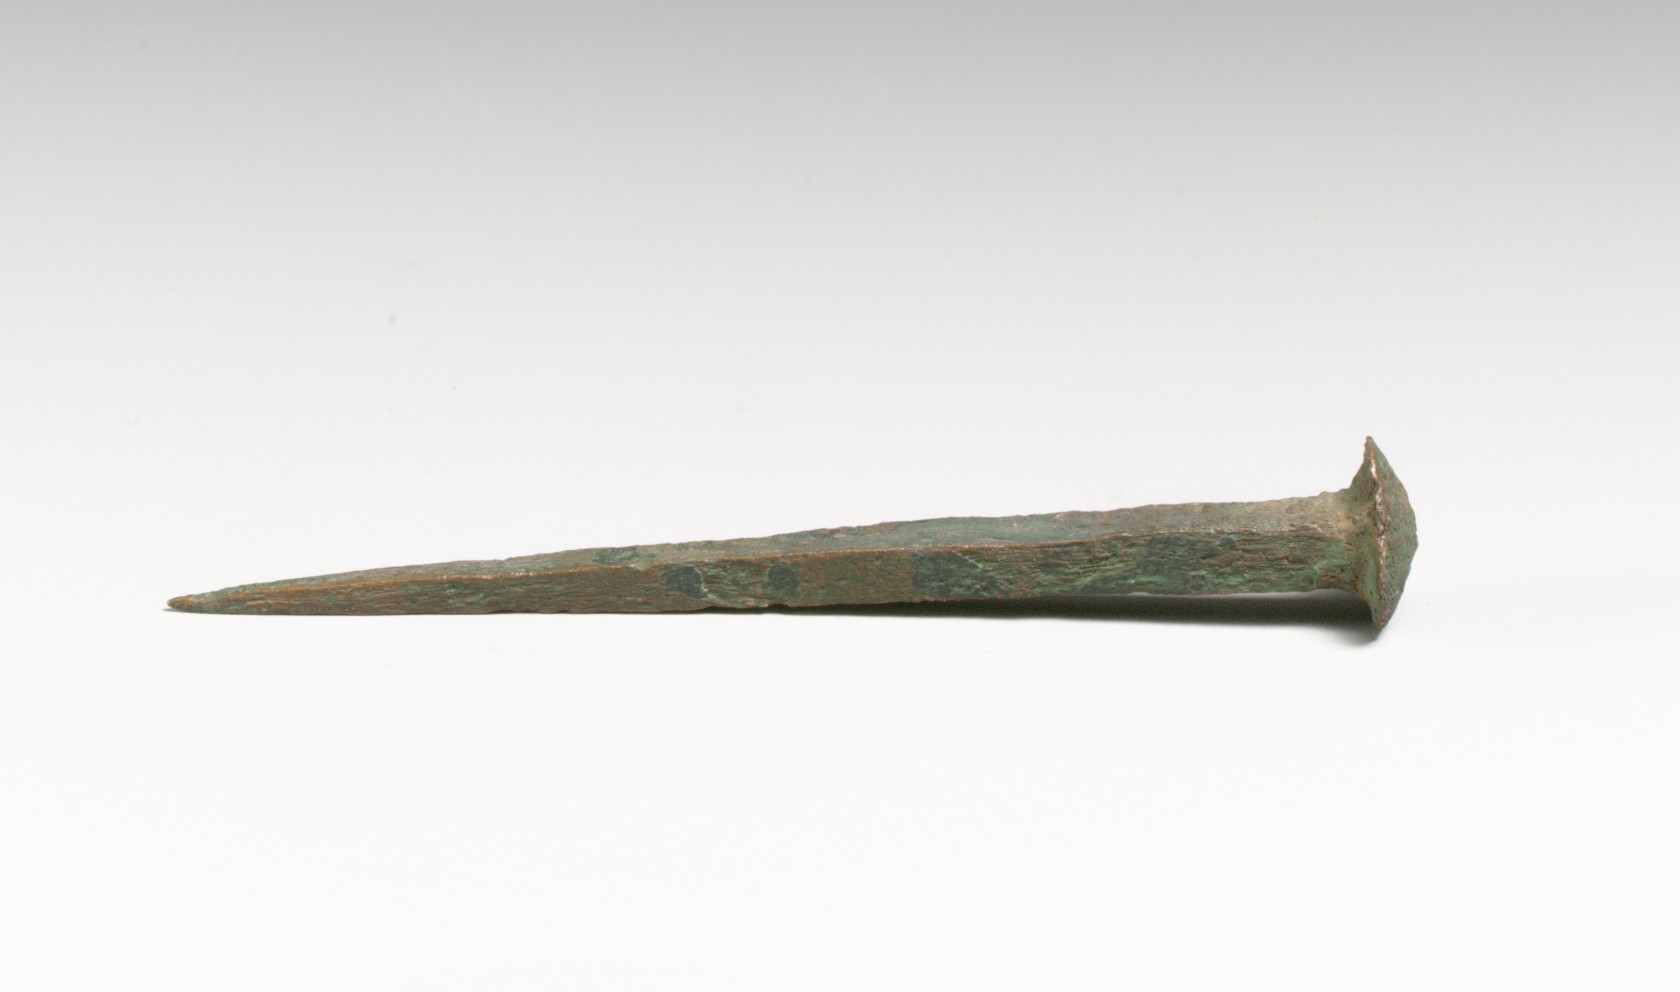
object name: nail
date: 7000 BCE-330 CE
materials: bronze